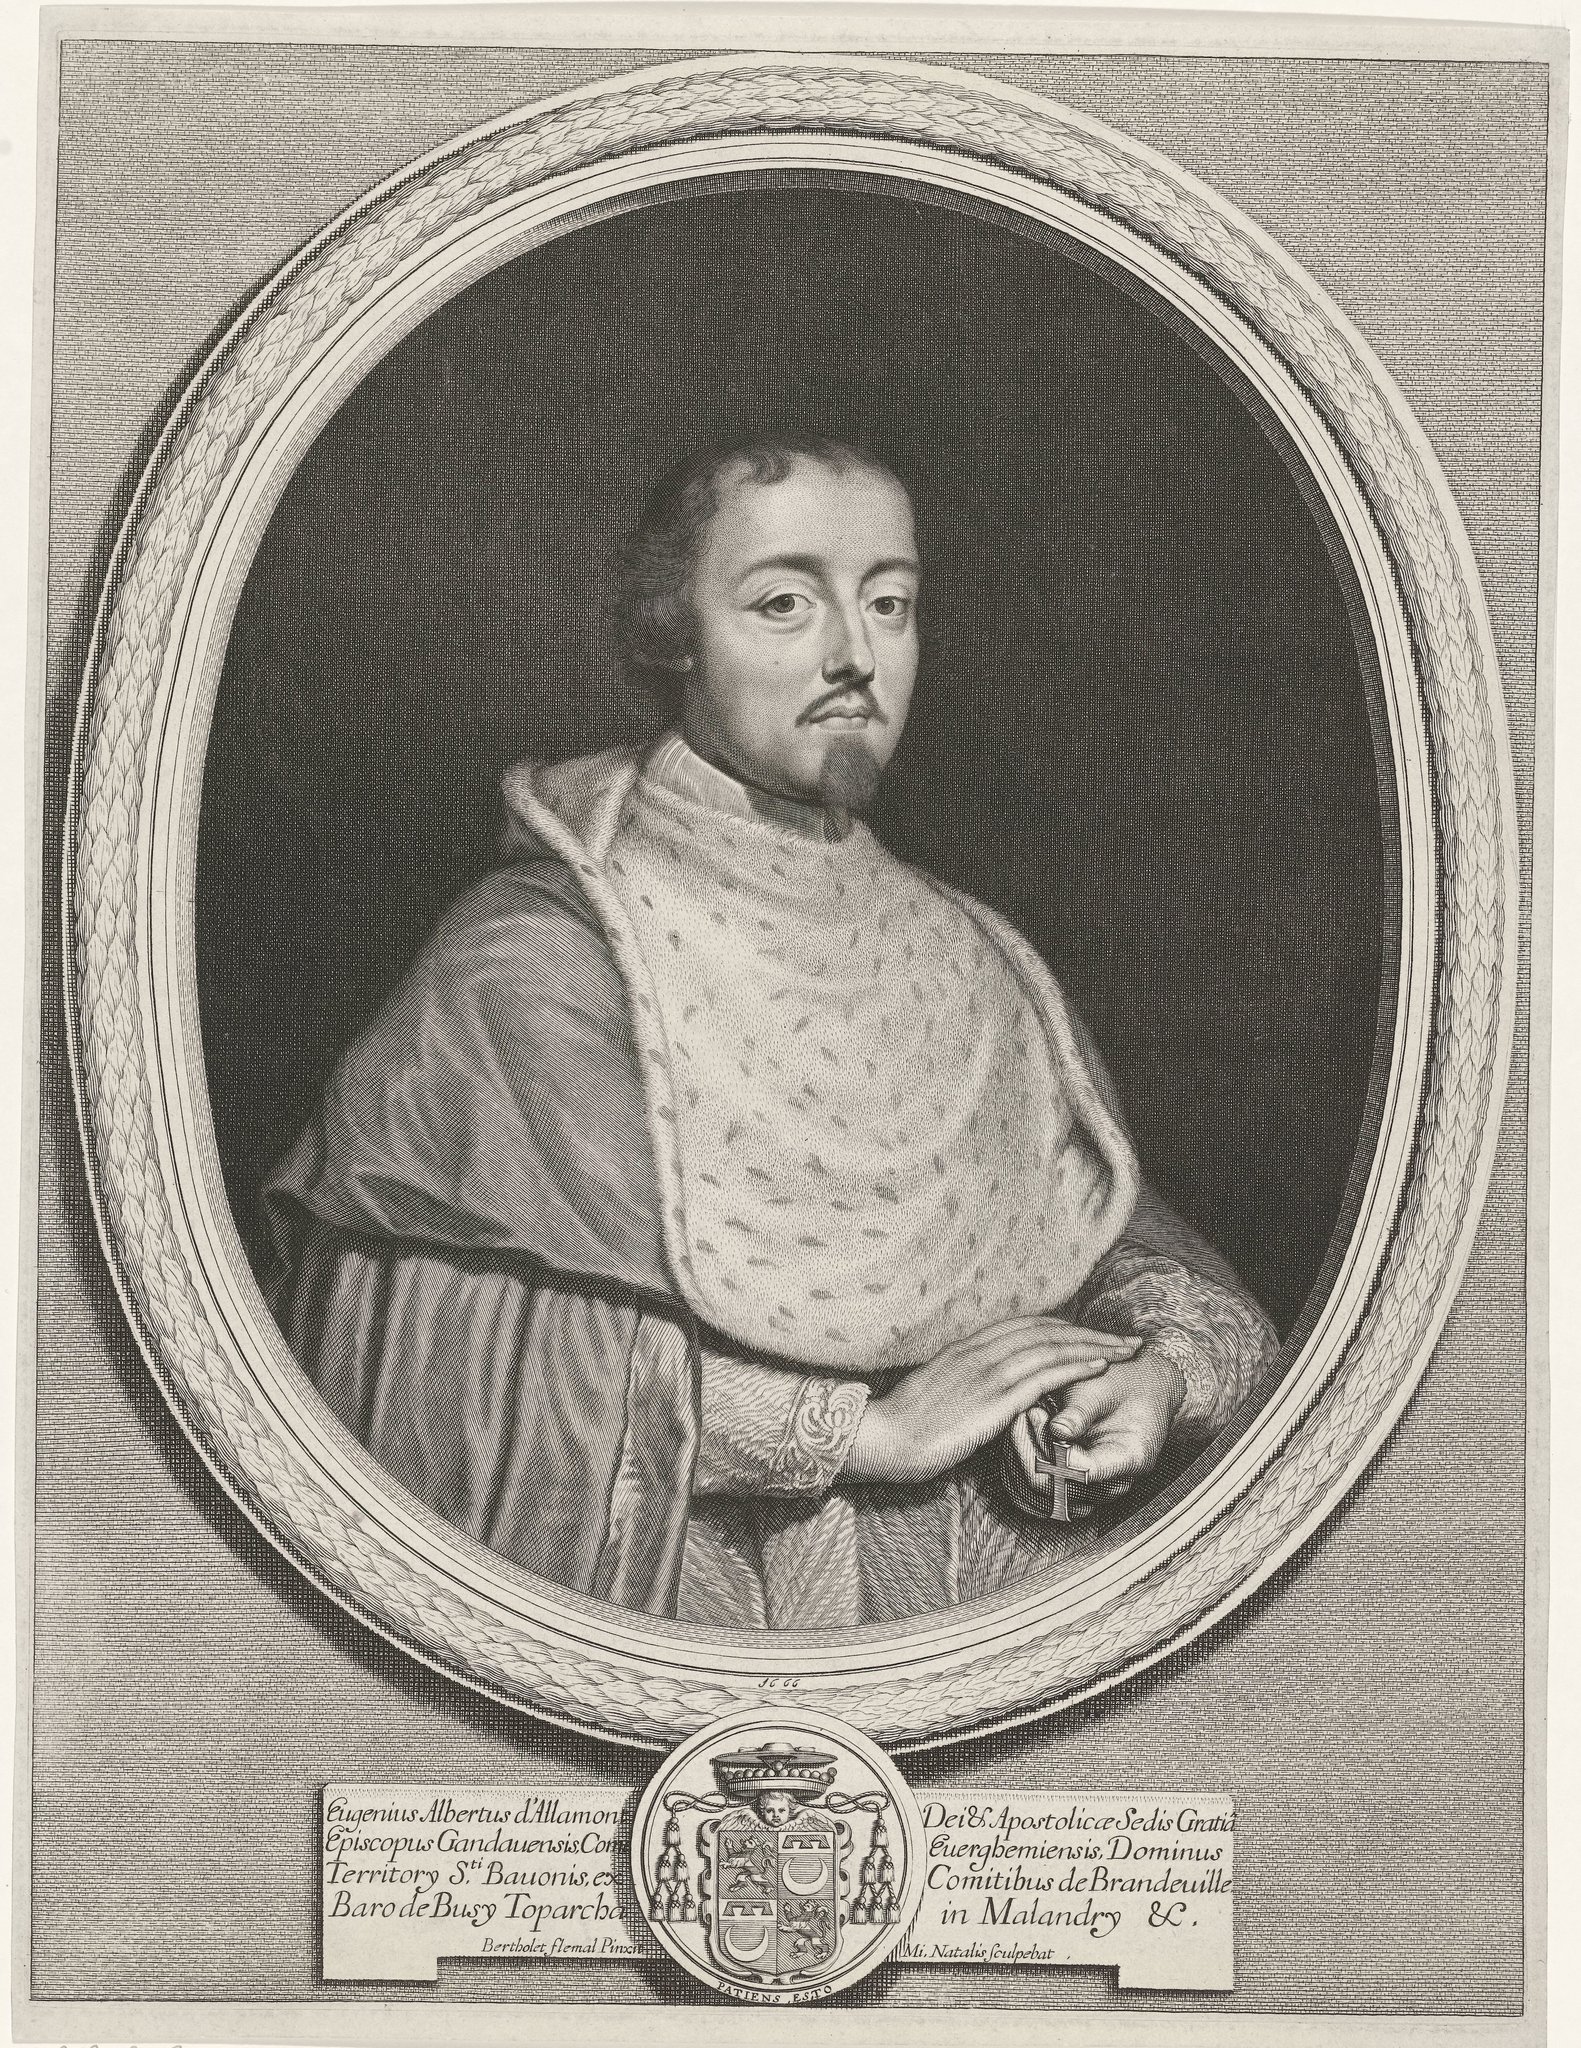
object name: print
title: Portret van Eugenius Albertus d' Allamont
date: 1666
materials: paper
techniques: engraving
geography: southern netherlands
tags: madrid, bisschop, eugenius albertus d' allamont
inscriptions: collector's mark: Lugt 2228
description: Portret van Eugenius Albertus d' Allamont, bisschop te Gent, gekleed in bisschoppelijke mantel. Buste naar rechts in een ovale lijst versierd met een lauwerkrans. Onderaan in de marge zijn wapen en een vierregelige tekst in het Latijn.